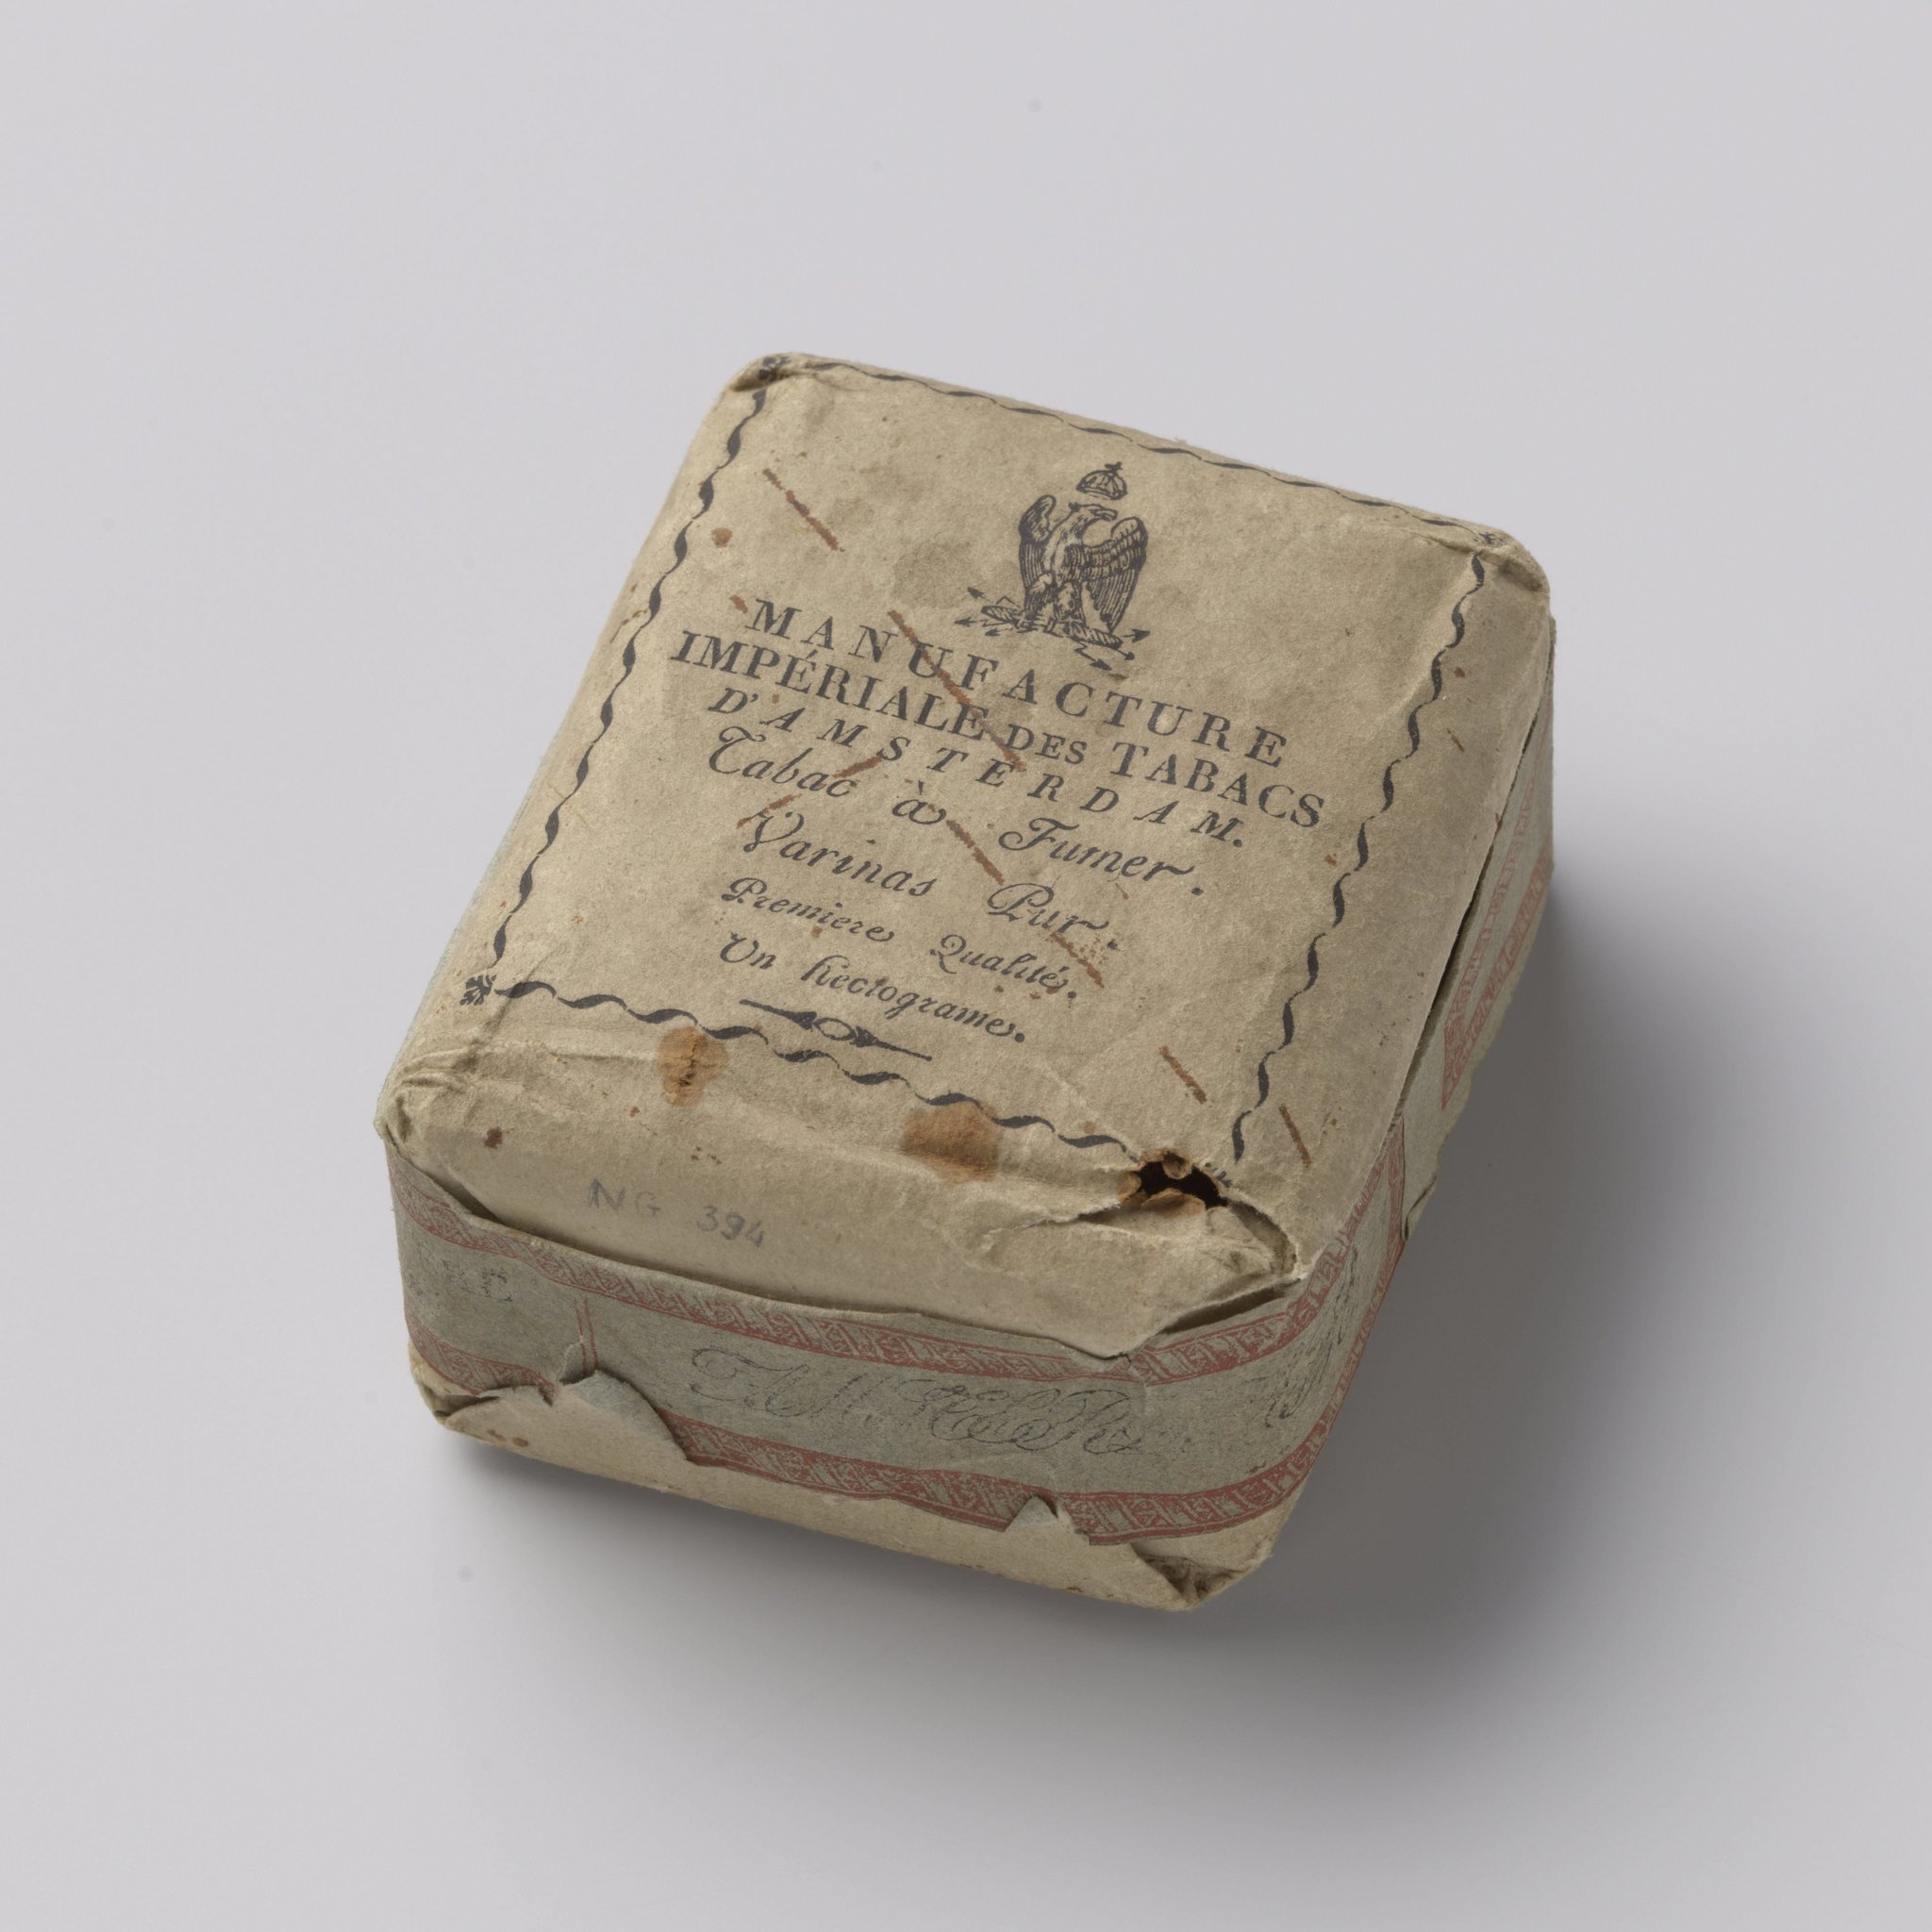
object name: tobacco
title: Régie-tabak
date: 1810-1813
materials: paper, plant material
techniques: treatment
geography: amsterdam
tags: amsterdam